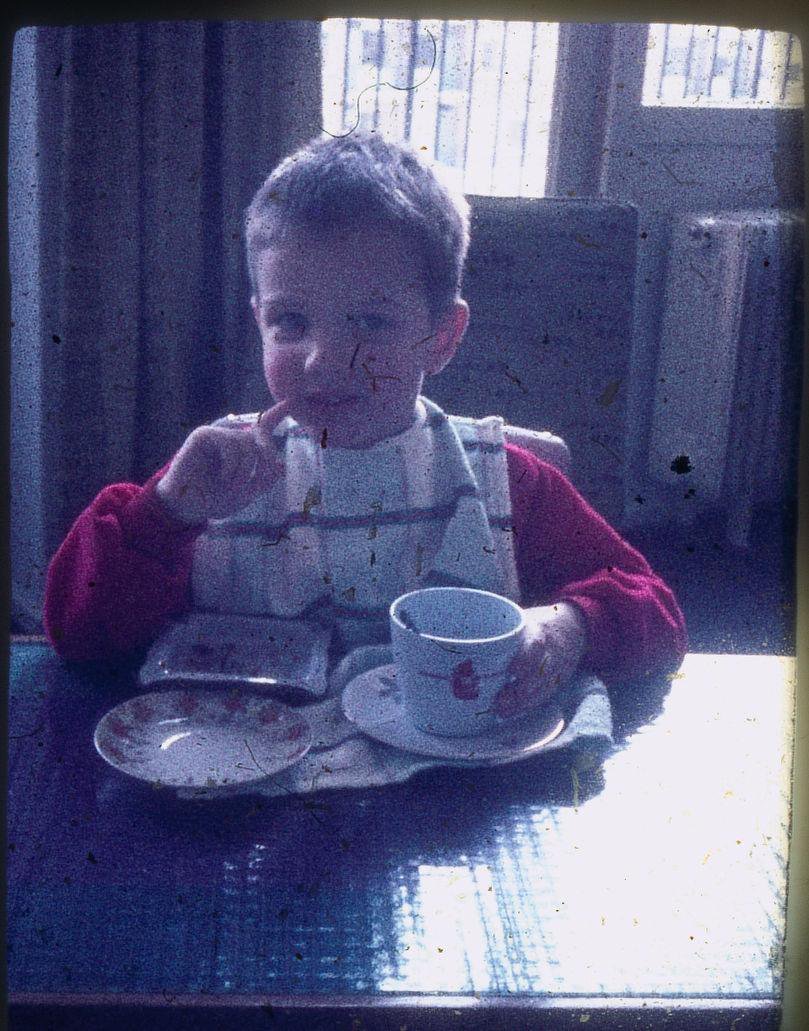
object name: photograph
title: Portret van een kind met slabbetje voor, gezeten aan de eettafel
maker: Anonymous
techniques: slide